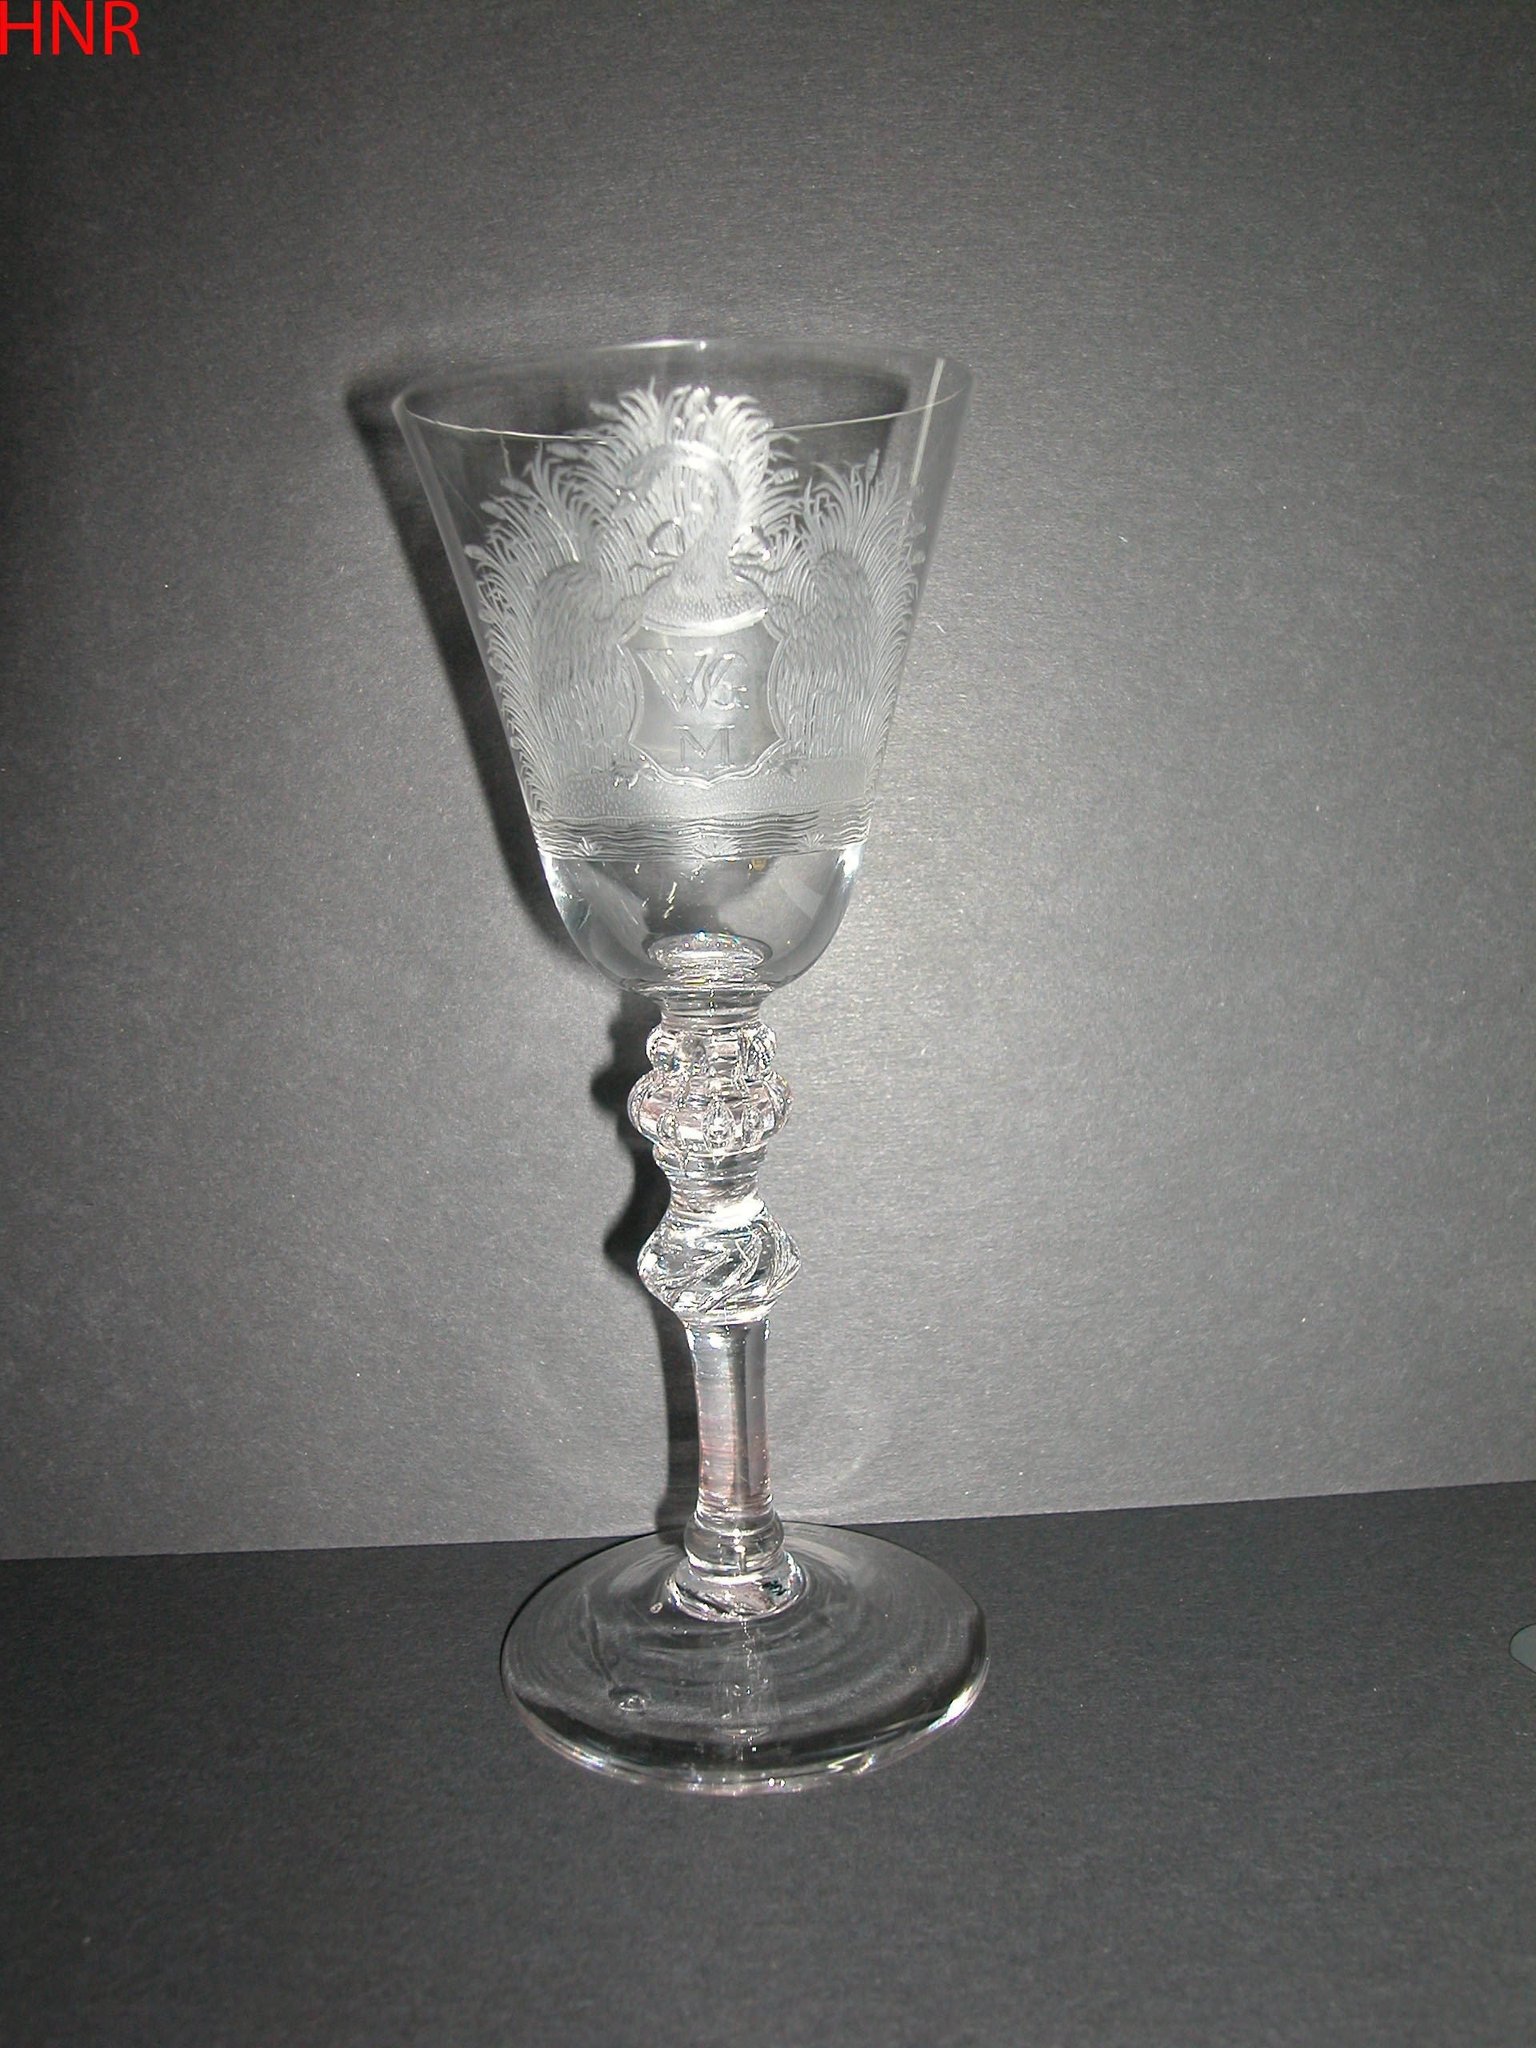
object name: goblet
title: Kelkglas met het wapen van de familie Van Lennep en het monogram WGM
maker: Anonymous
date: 1750-1775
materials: glass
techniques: glassblowing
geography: northern netherlands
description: Coat of arms of Watergraafsmeer Polder Board, 1787. On loan from the Koninklijk Oudheidkundig Genootschap.